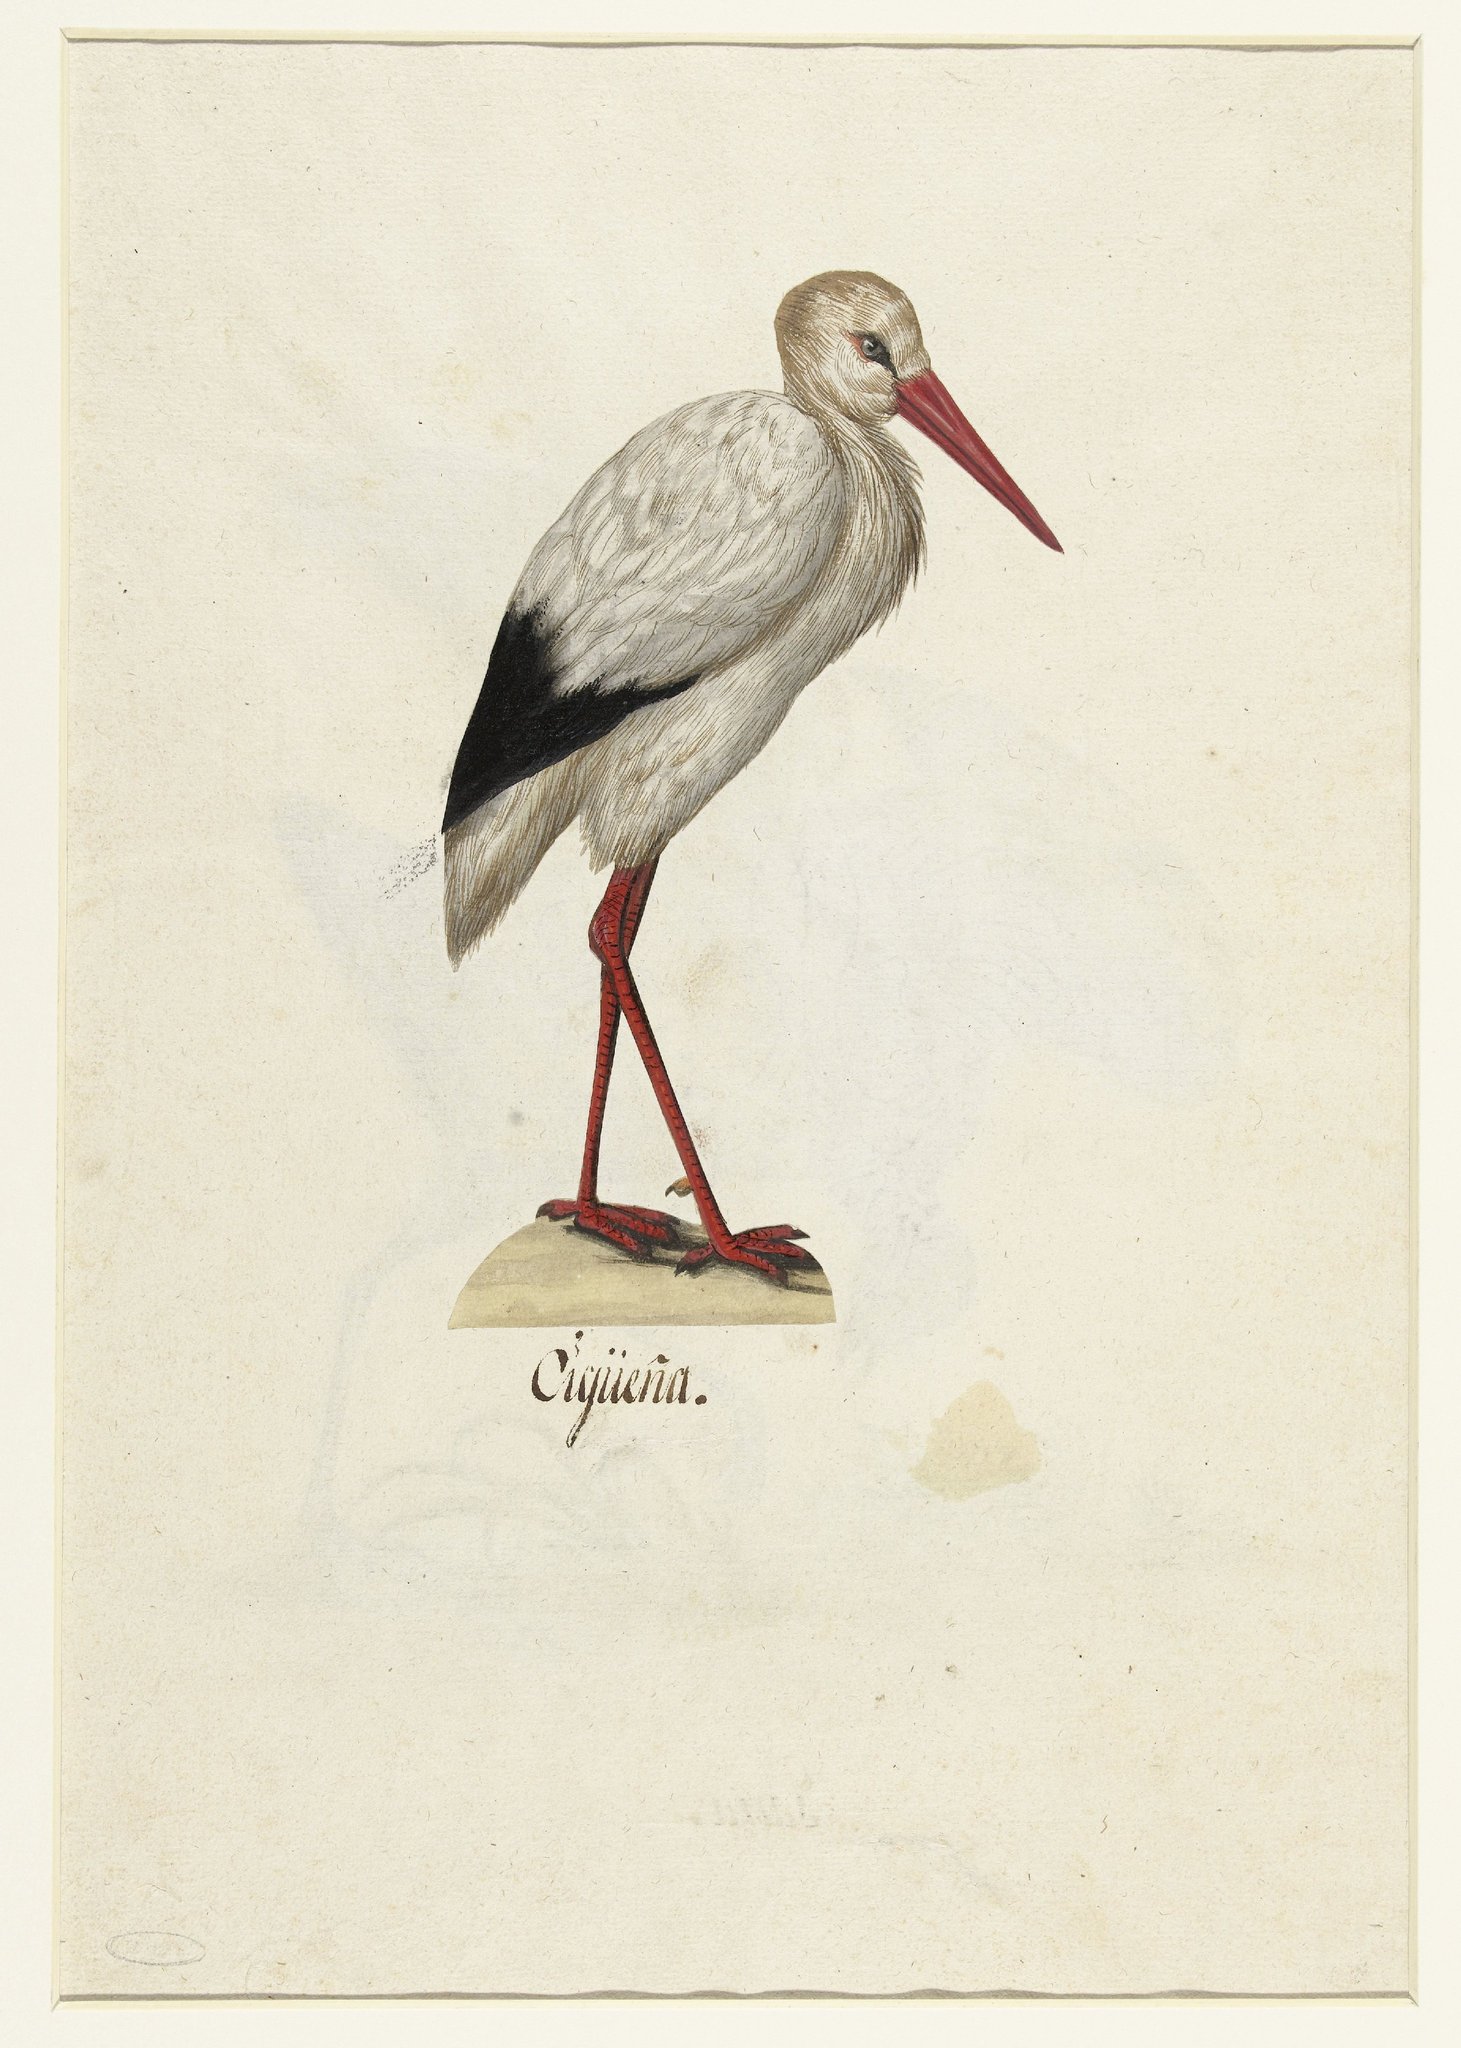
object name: drawing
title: Ooievaar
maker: Anonymous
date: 1560-1585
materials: ink, paper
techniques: brush, pen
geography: low countries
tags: shore-birds and wading-birds: white stork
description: Blad uit album van 100 (?) bladen met tekeningen van dieren.